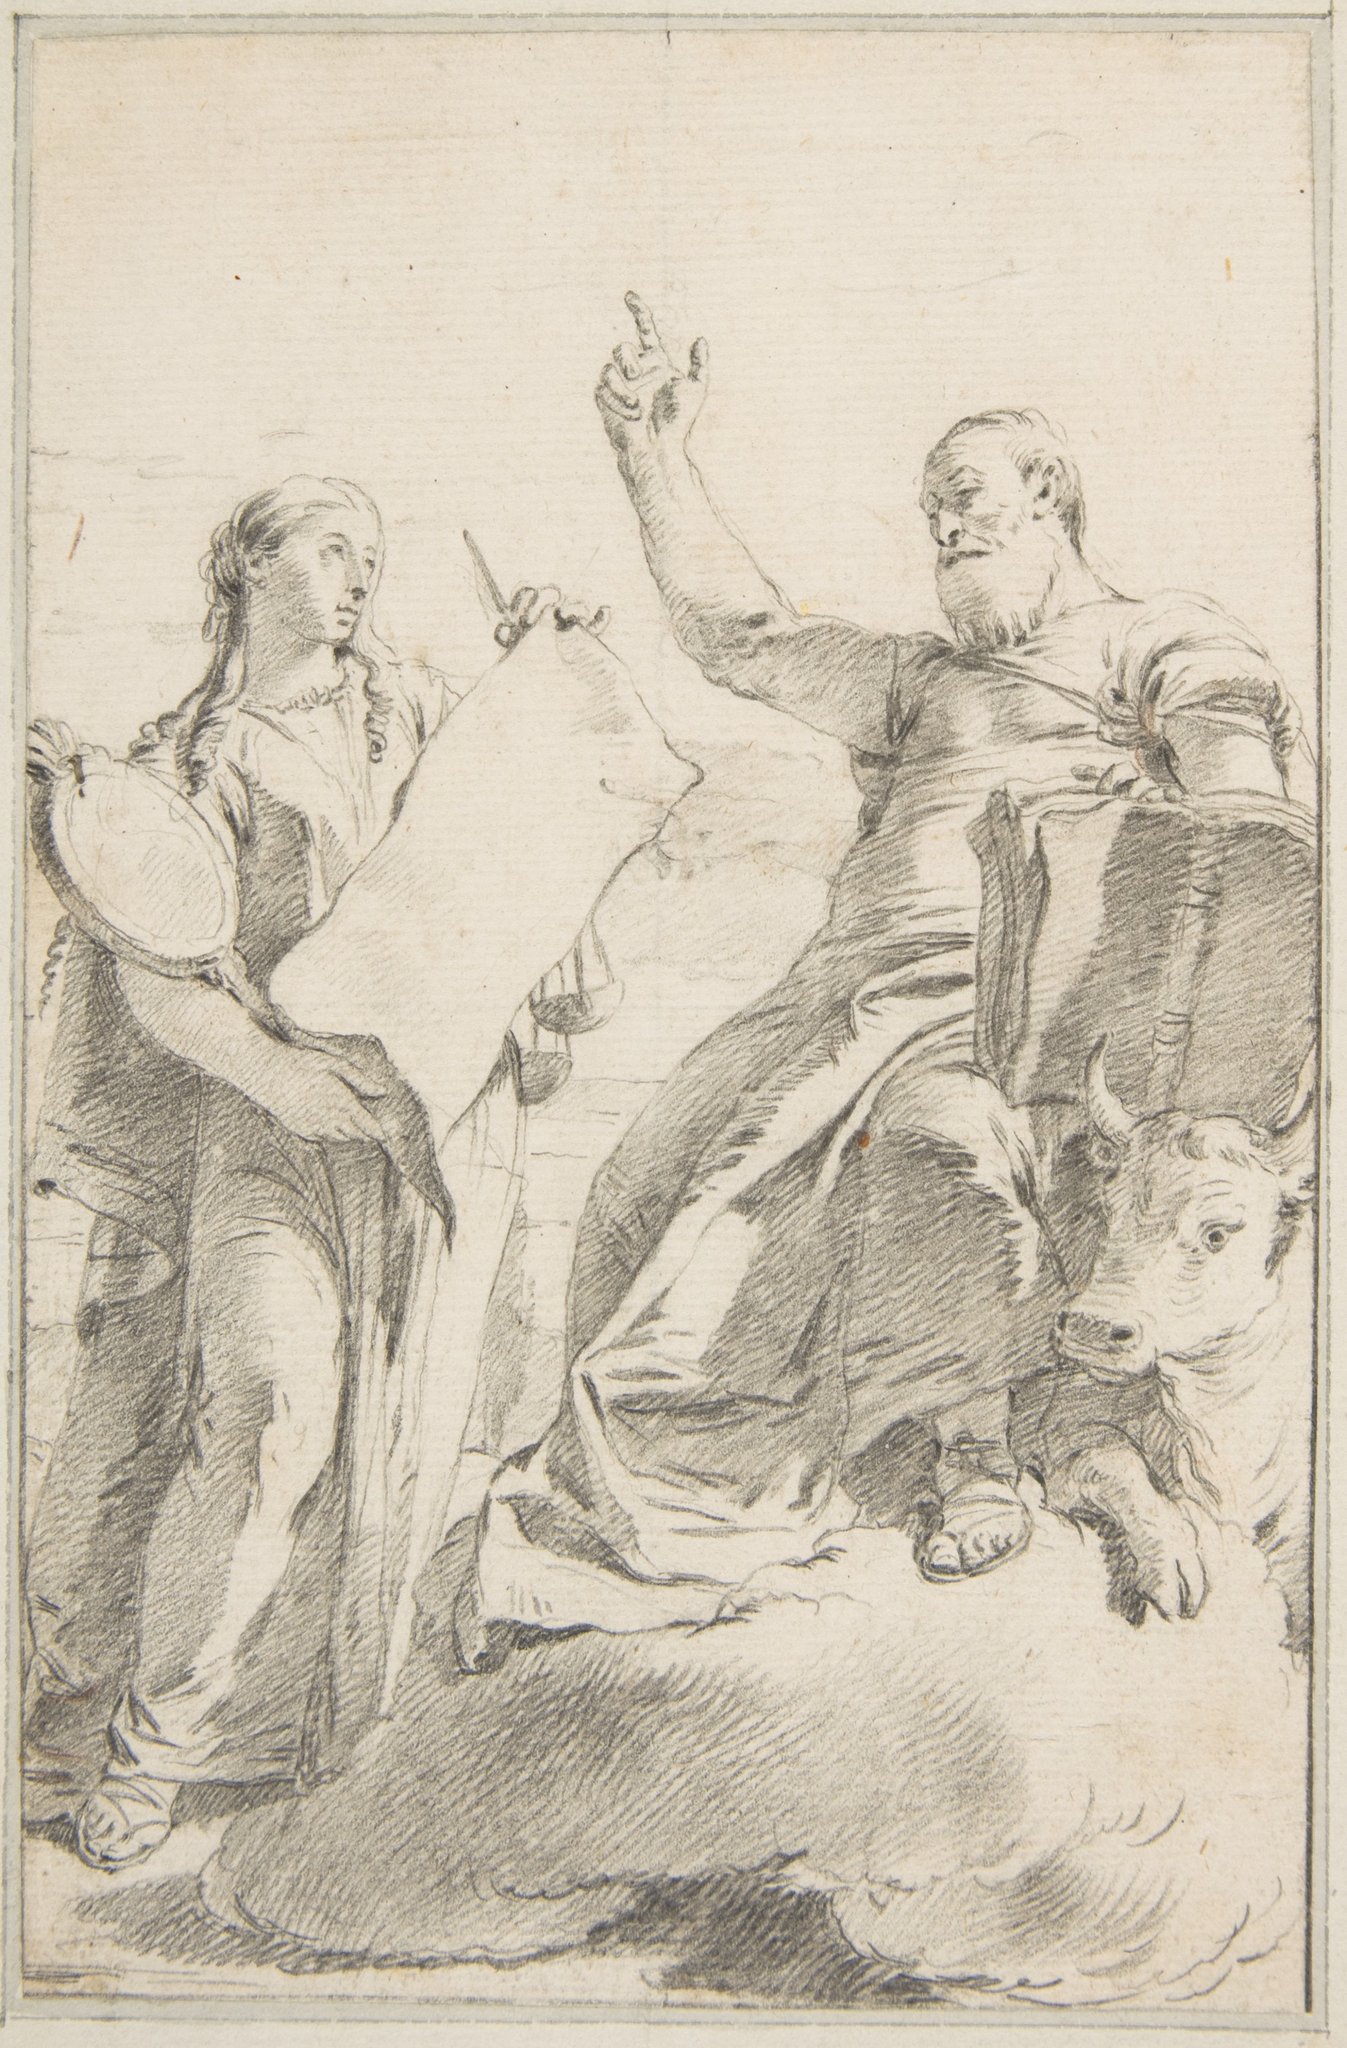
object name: drawing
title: Illustration for a Book: Saint Luke with a Female Allegorical Figure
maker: giovanni battista tiepolo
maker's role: artist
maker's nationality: italian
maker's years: 1696-1770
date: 1696-1770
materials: chalk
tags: women,cows,saints